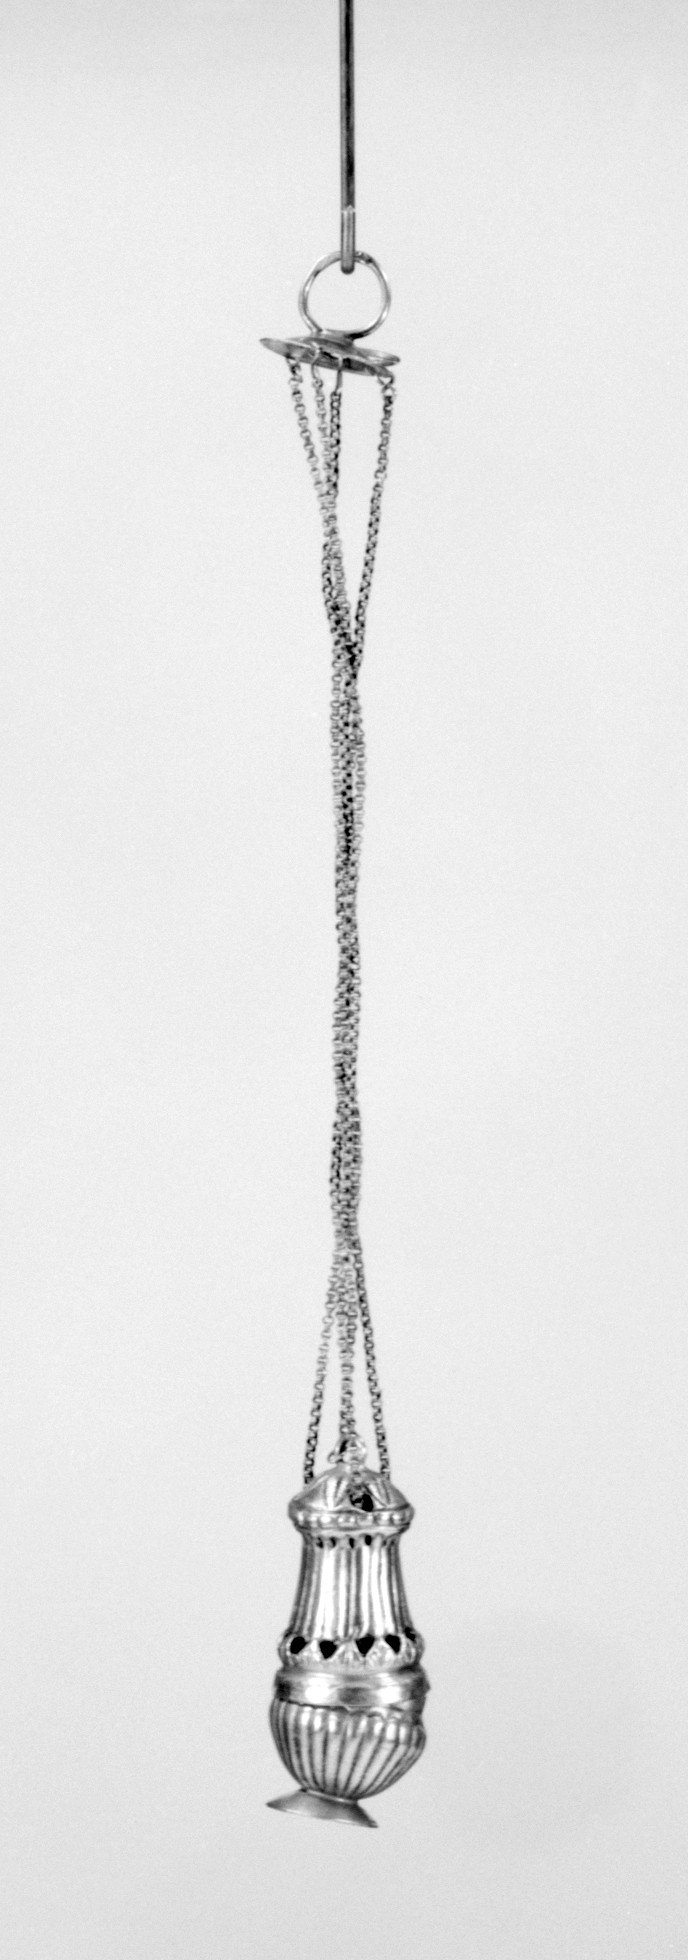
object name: crèche figure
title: Censer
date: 1751-1800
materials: gilt copper